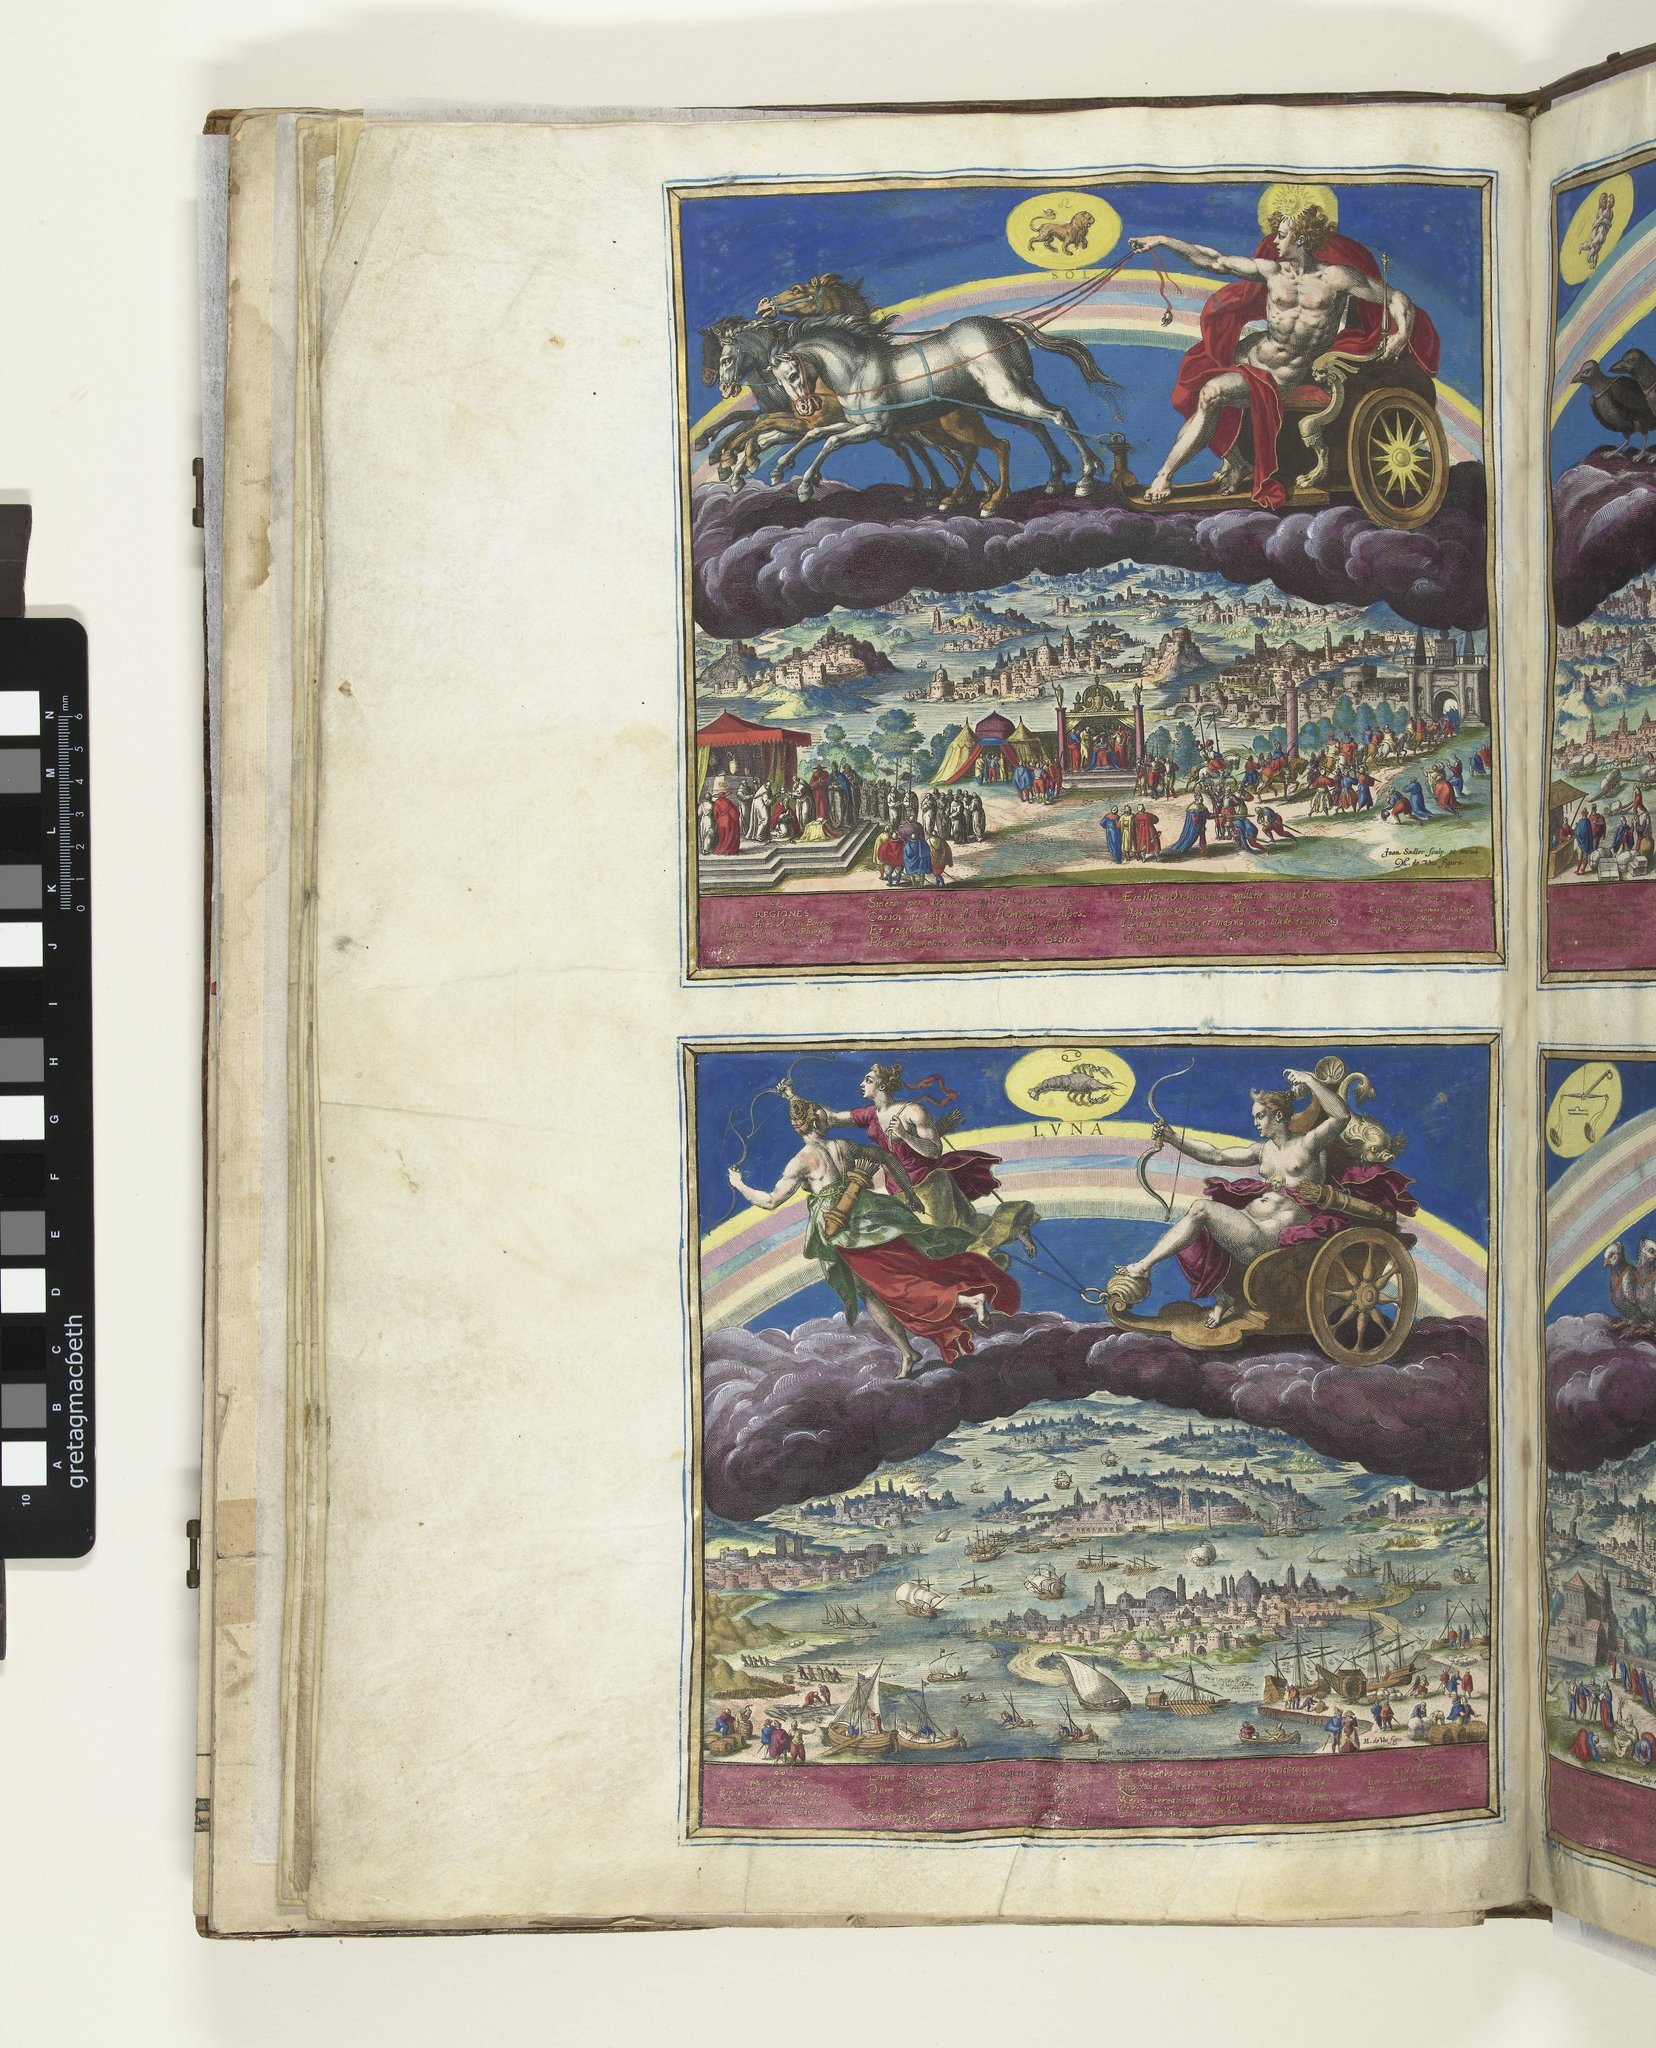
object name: print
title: De Zon en zijn invloed op de wereld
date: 1585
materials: paper, parchment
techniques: engraving, hand coloring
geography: antwerp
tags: papal coronation, (personifications of the) planets with their 'children', so-called 'planetenkinder', accompanied by the corresponding zodiacal signs, the chariot of the sun, triumphal entry and public reception, pageant, 'entrée solennelle', 'joyeuse entrée', coronation of a ruler, leo (zodiacal sign of july), becoming a knight, knighting, italy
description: De god Apollo als Sol, op de wolken rijdend op zijn zegewagen, die wordt getrokken door vier paarden. Middenboven het sterrenbeeld Leeuw. Onderaan een heuvelachtig landschap (Italië en Bohemen) waarin verschillende hoogwaardigheidsbekleders. Links wordt een paus gekroond. In het midden de kroning van een koning en het tot ridder slaan van een man. Rechts een koninklijke intrede. Onder de voorstelling een lofdicht in het Latijn over de invloed van de zon op de streken Italië en Bohemen. Deze prent maakt deel uit van een album.